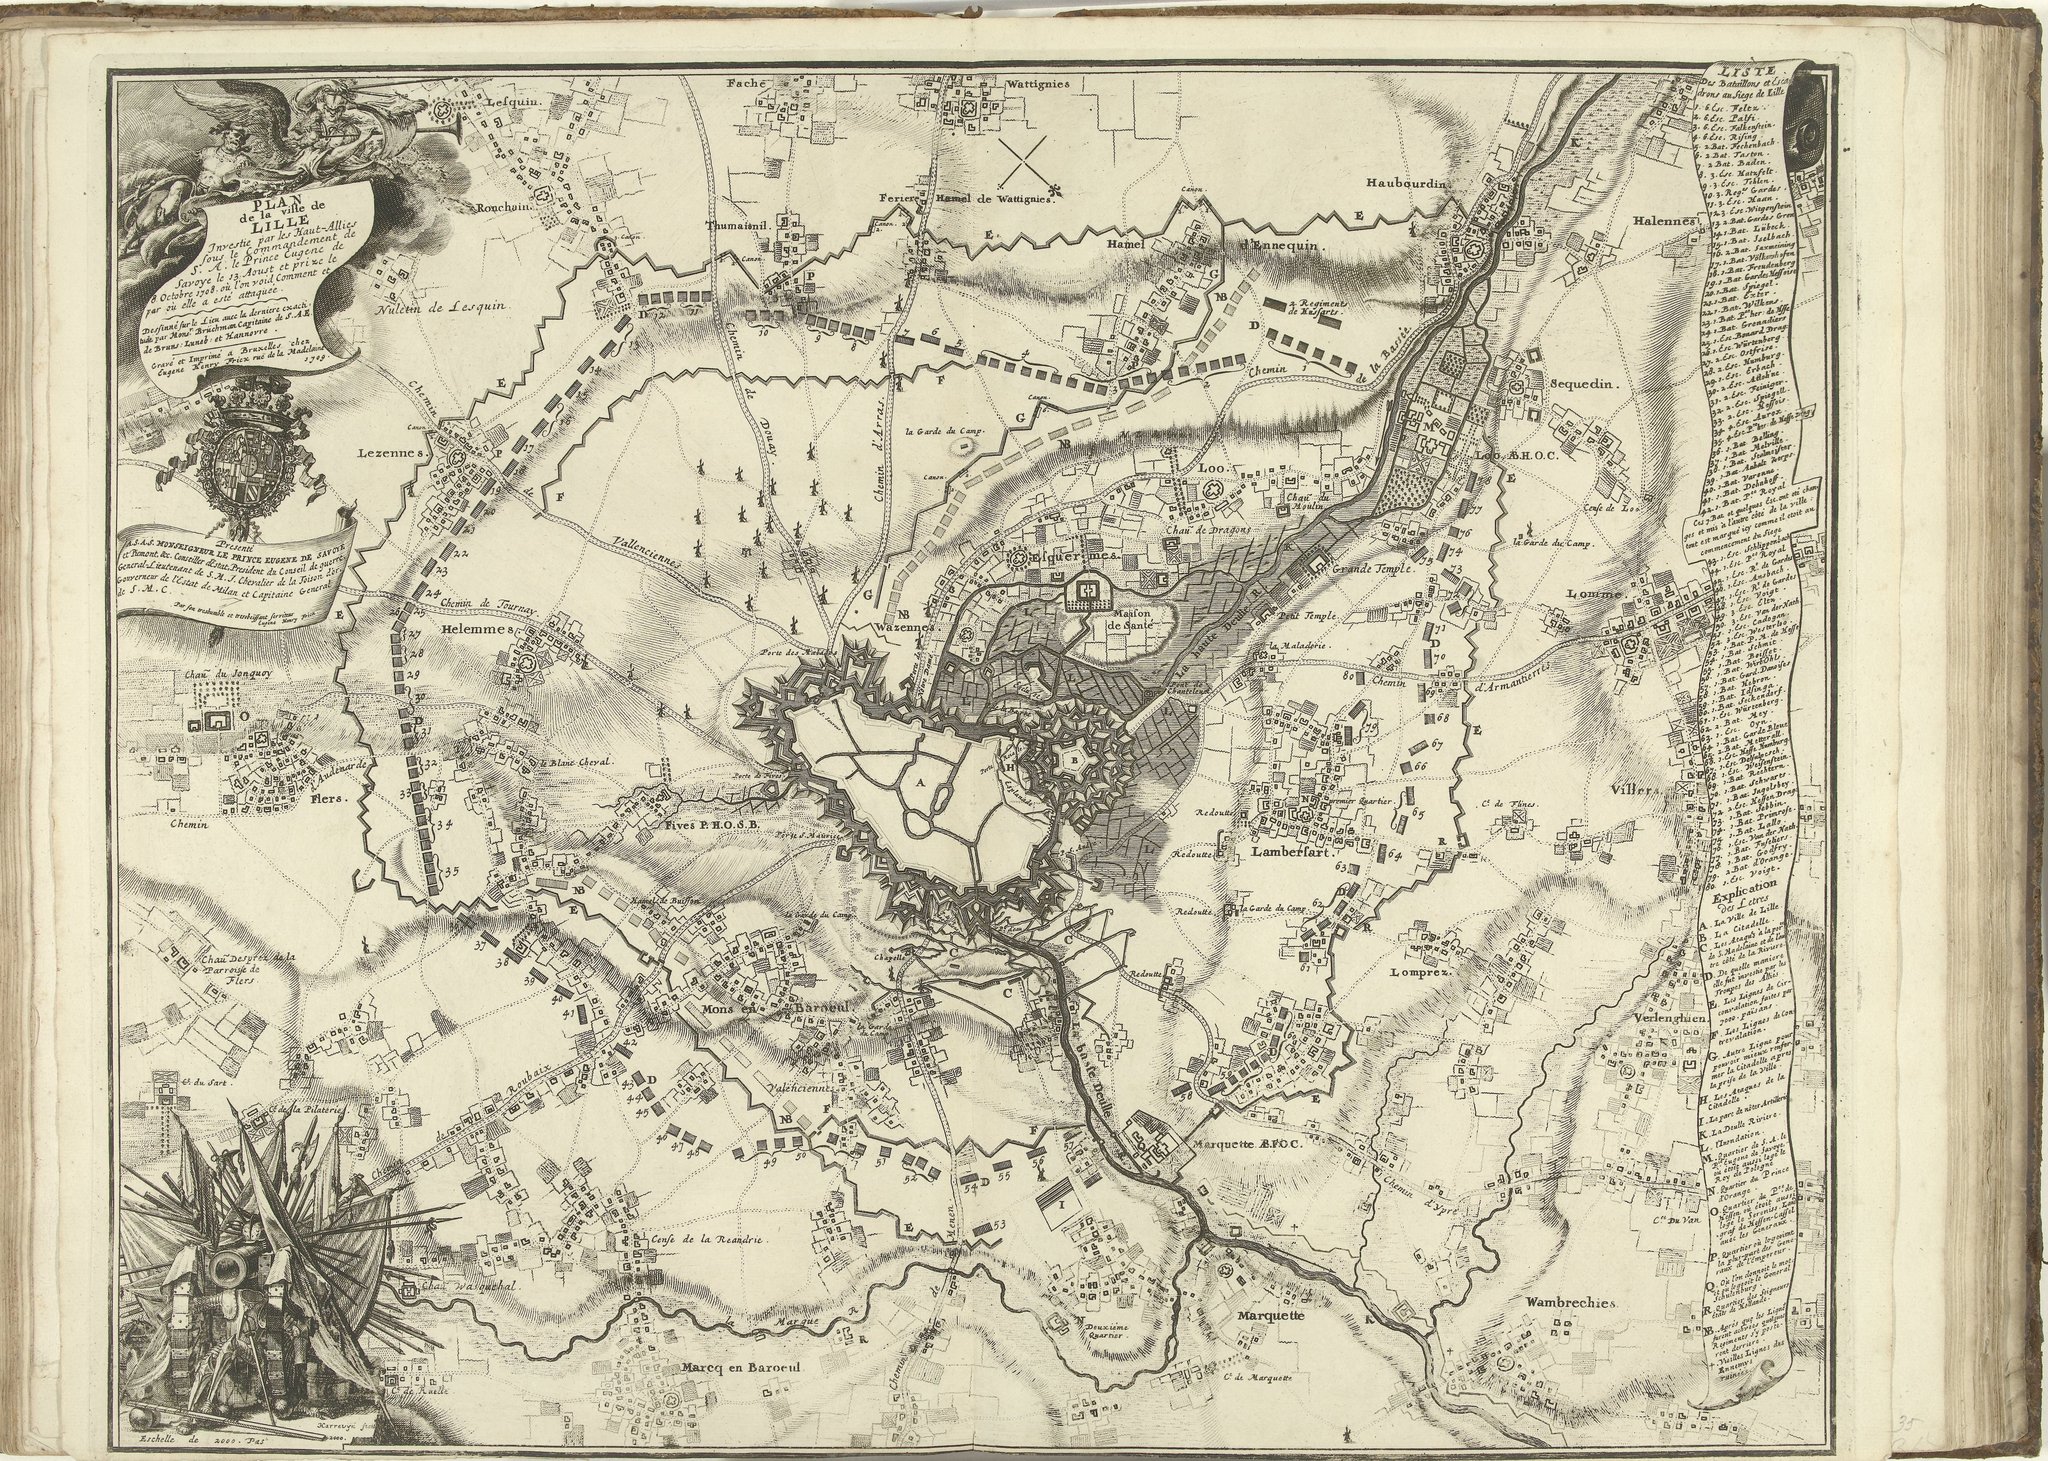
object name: print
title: Kaart van het beleg van Lille, 1708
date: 1709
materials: paper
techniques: engraving, etching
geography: brussels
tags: paris, vienna, eugenius van savoye, maps of separate countries or regions, siege, position war, lille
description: Kaart van Lille (Rijssel) met het kasteel, belegerd vanaf 22 augustus 1708 door de Geallieerden onder prins Eugenius van Savoye. Rechts een banderol met de legenda 1-80 en A-R in het Frans. Onderdeel van een gebundelde verzameling van plannen van veldslagen en steden vermaard in de Spaanse Successieoorlog.